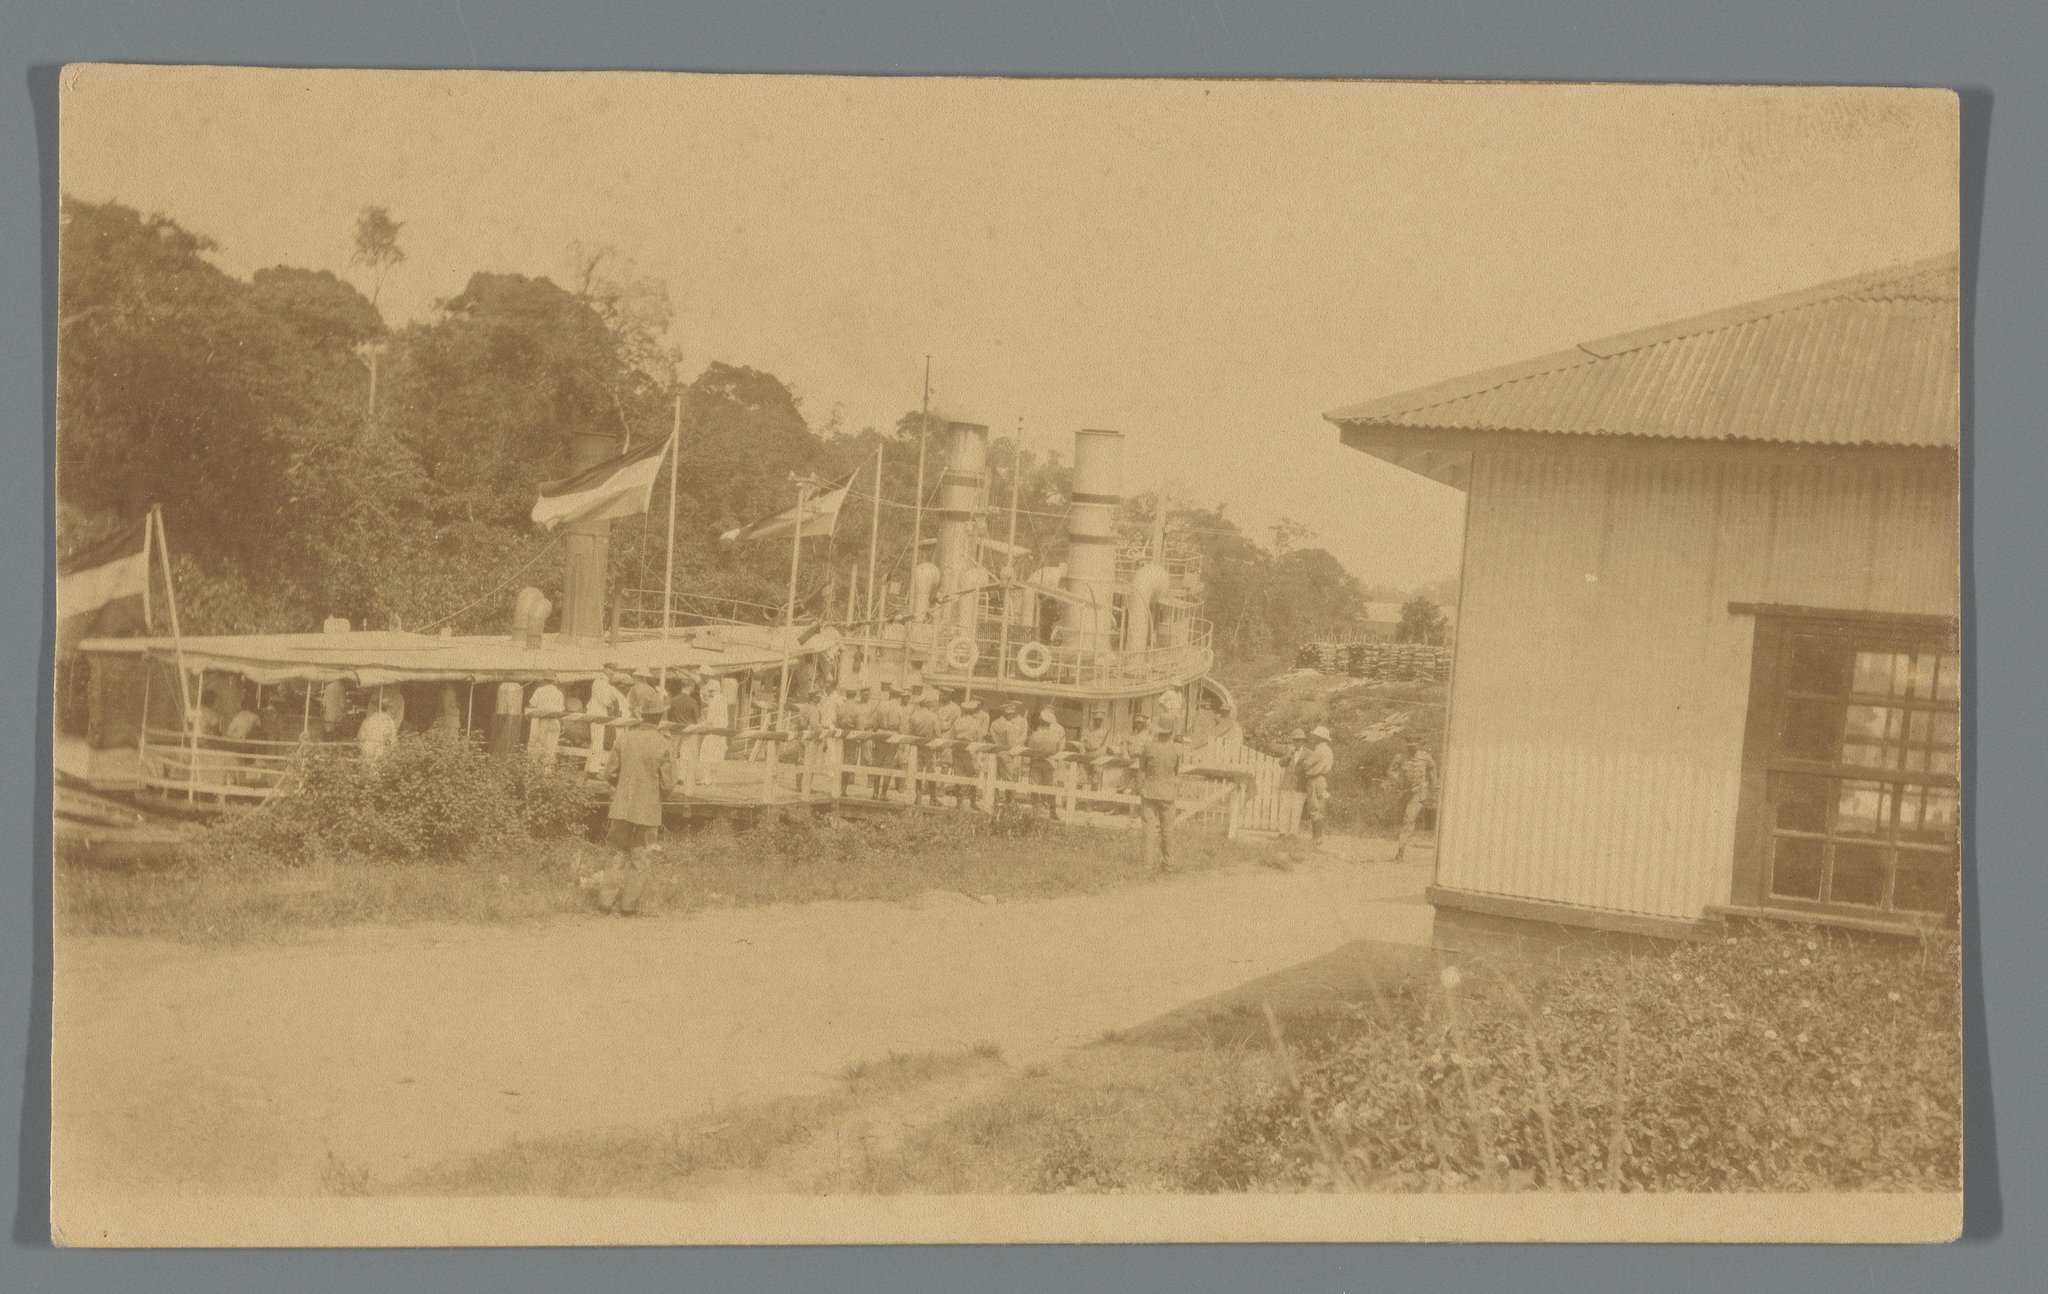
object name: ansichtkaart, prentbriefkaart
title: Aankomst van de gouverneur van Suriname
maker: Anonymous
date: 1925-1927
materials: photographic support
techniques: photography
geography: suriname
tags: jetten, familie, moengo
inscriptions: inscription: ‘Bezoek van Gouverneur’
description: Aankomst van een rivierboot met de gouverneur van Suriname, op de steiger staat een erewacht. Onderdeel van het ensemble met foto's van de familie van ingenieur Jetten in de mijnbouwstad Moengo in Suriname.